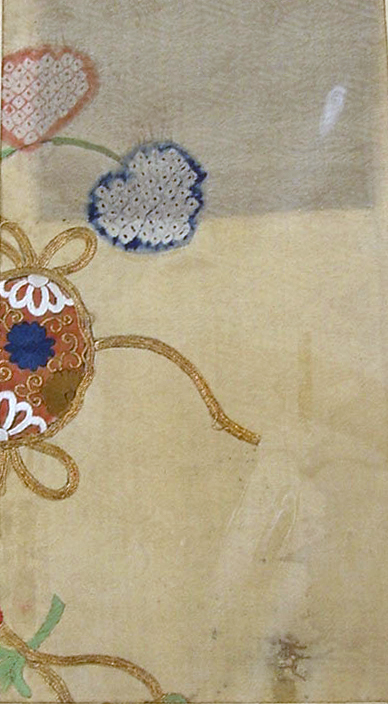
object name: piece from a kosode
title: Piece from a Kosode with Partial Decorative Ball (kusudama)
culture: japanese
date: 1615-1868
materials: metal thread, silk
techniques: damask, dyeing, embroidery, resist